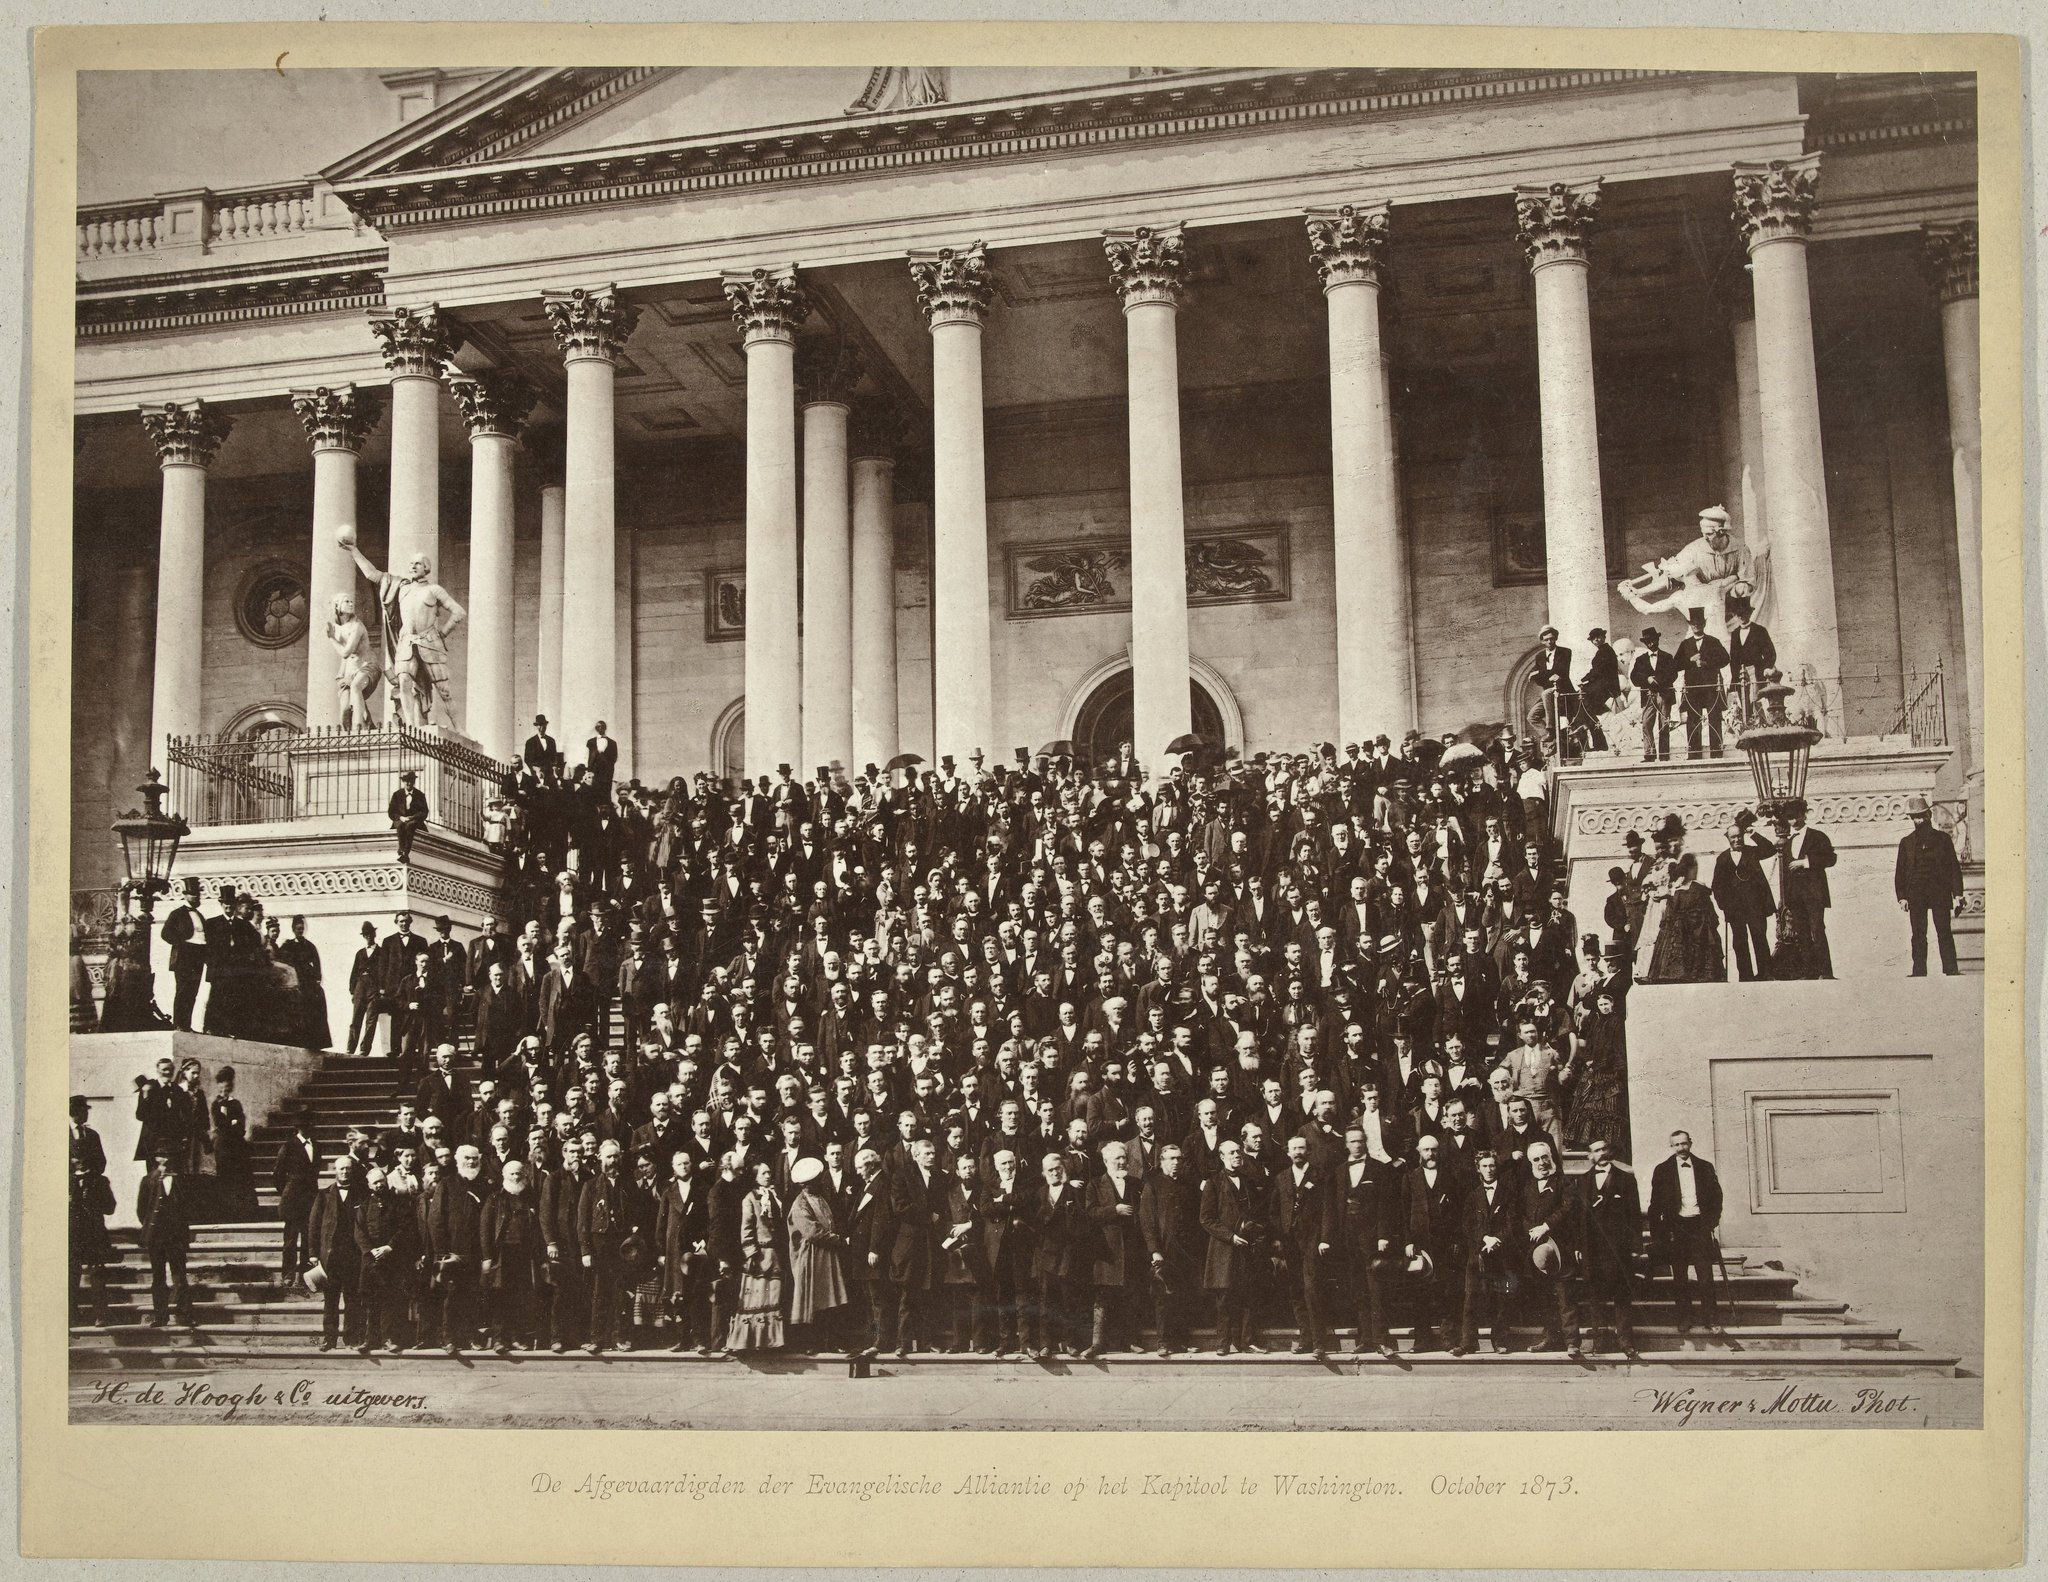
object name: fotomechanisch procedé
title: De afgevaardigden der Evangelische Alliantie op de trappen van het Capitool te Washington, D.C.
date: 1810-1873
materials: paper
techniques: photograph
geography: amsterdam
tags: anonymous historical persons portrayed in a group, in a group-portrait